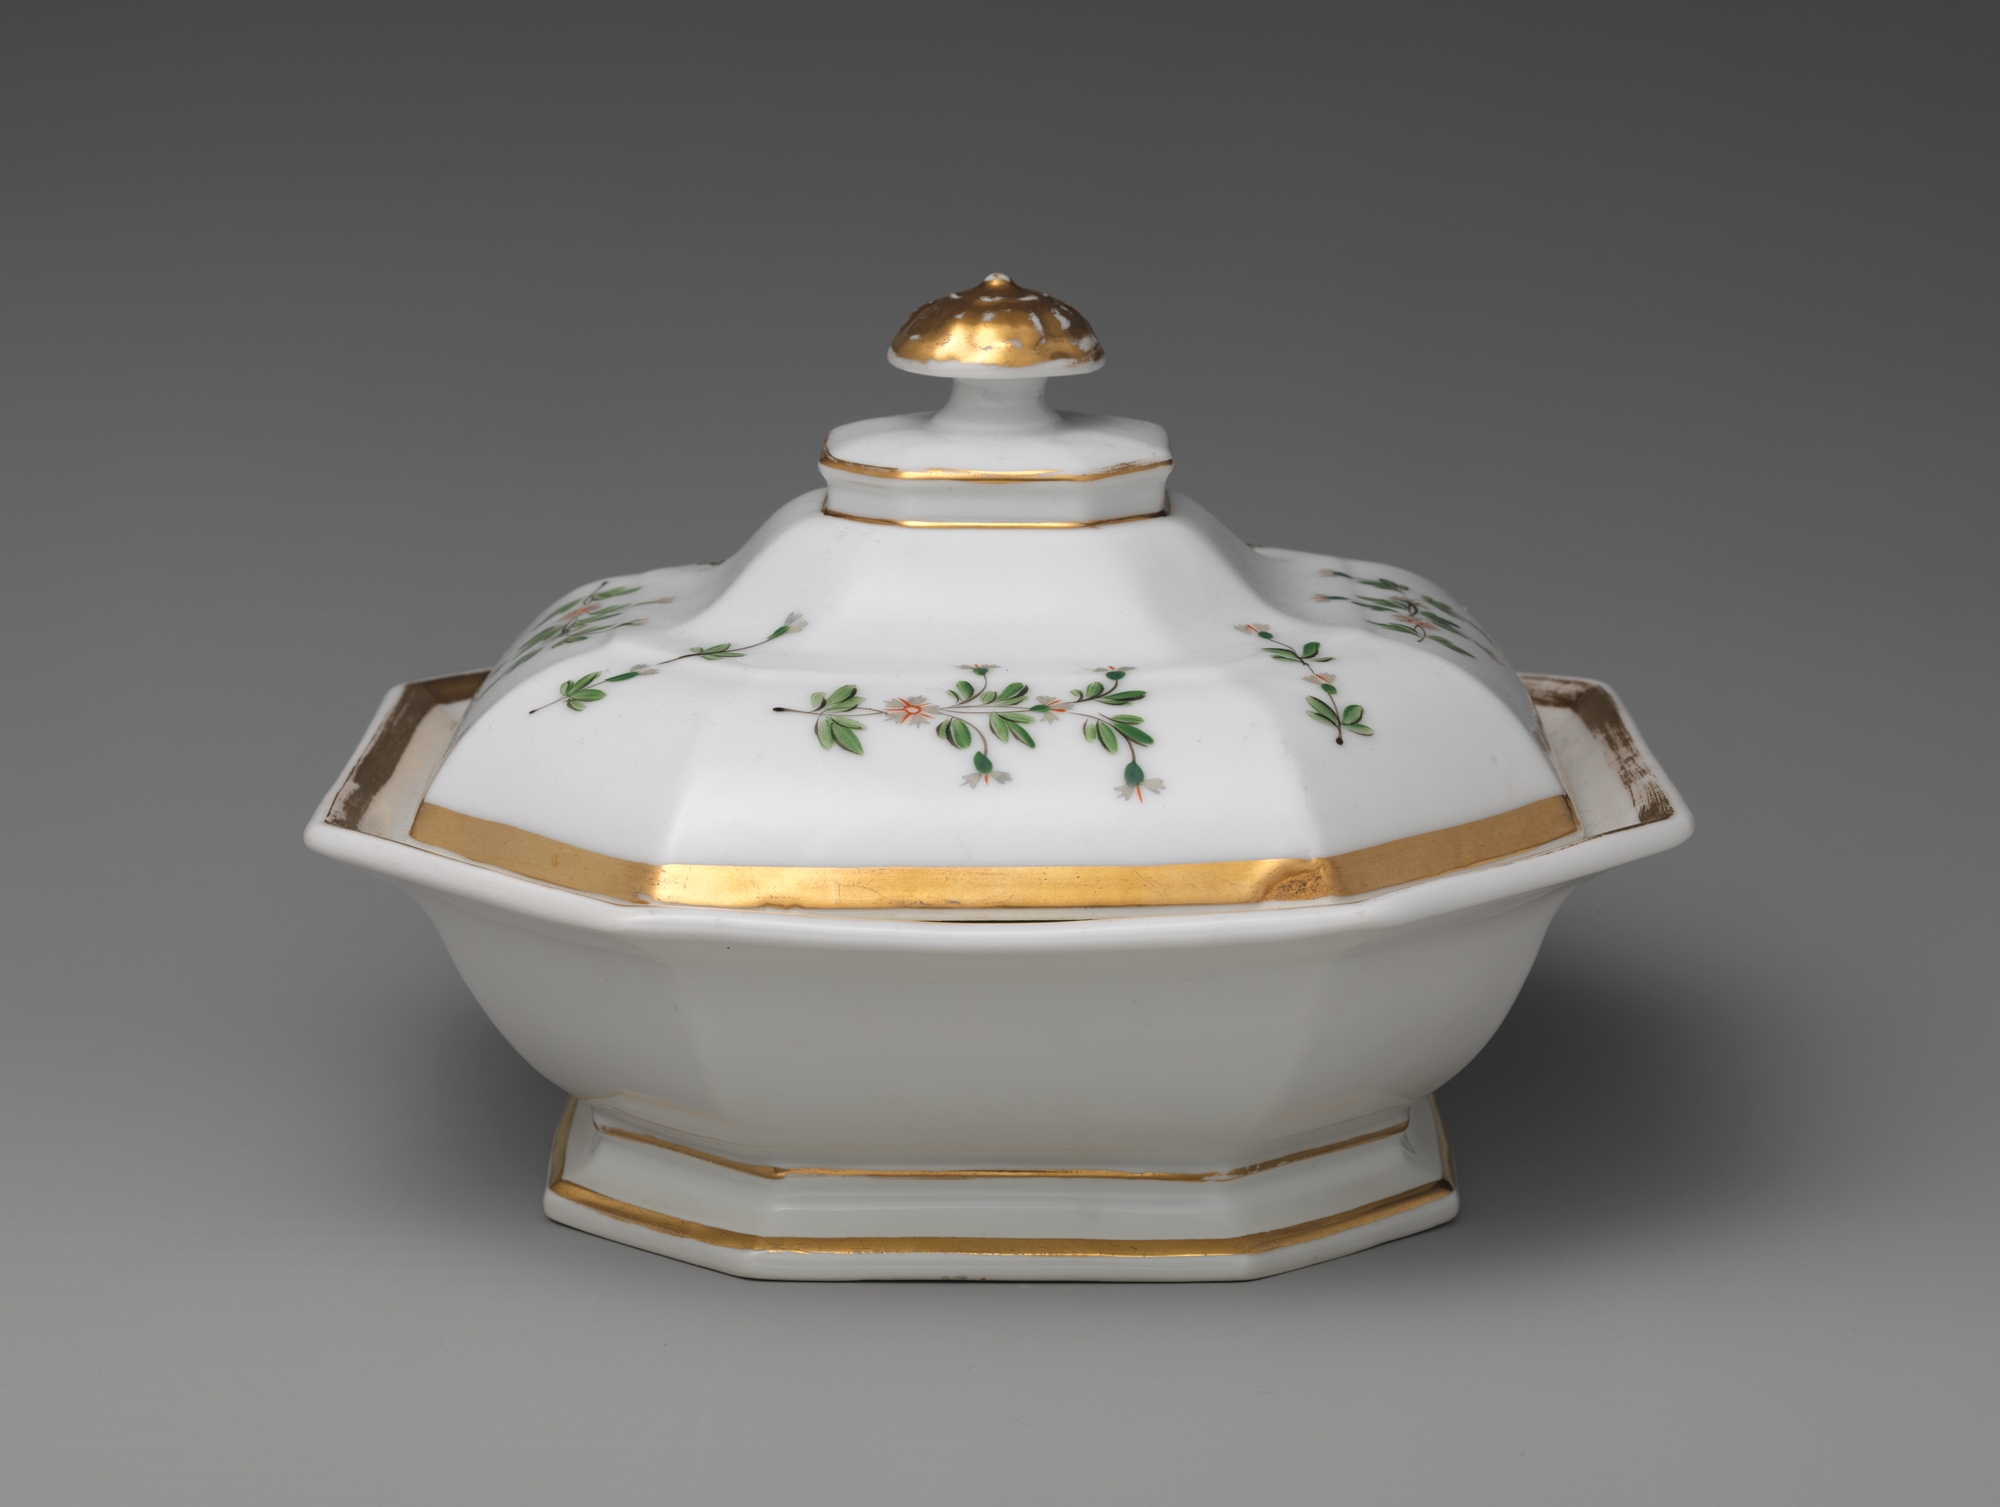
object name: dish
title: Covered Dish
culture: french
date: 1815-1830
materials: porcelain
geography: france